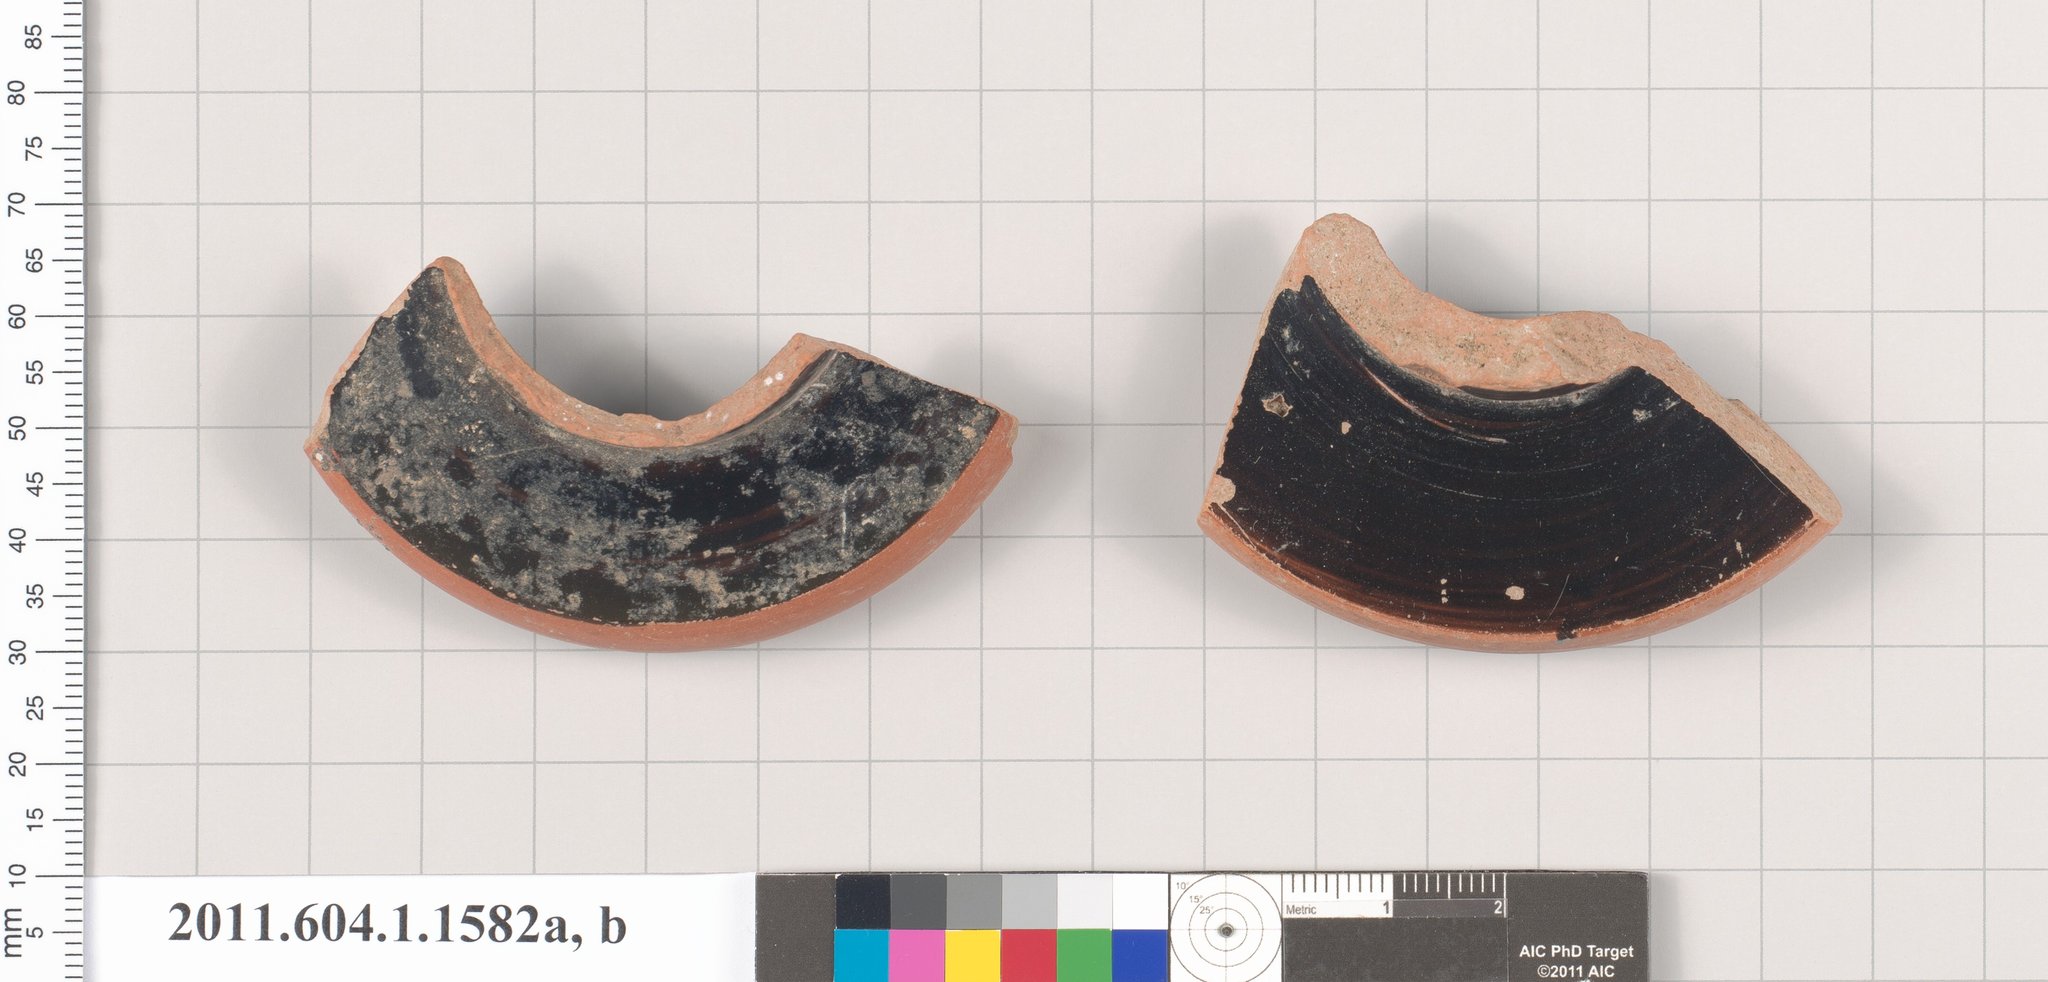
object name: kylix fragment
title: Terracotta fragments of kylikes (drinking cups)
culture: greek, attic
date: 500-401 BCE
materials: terracotta